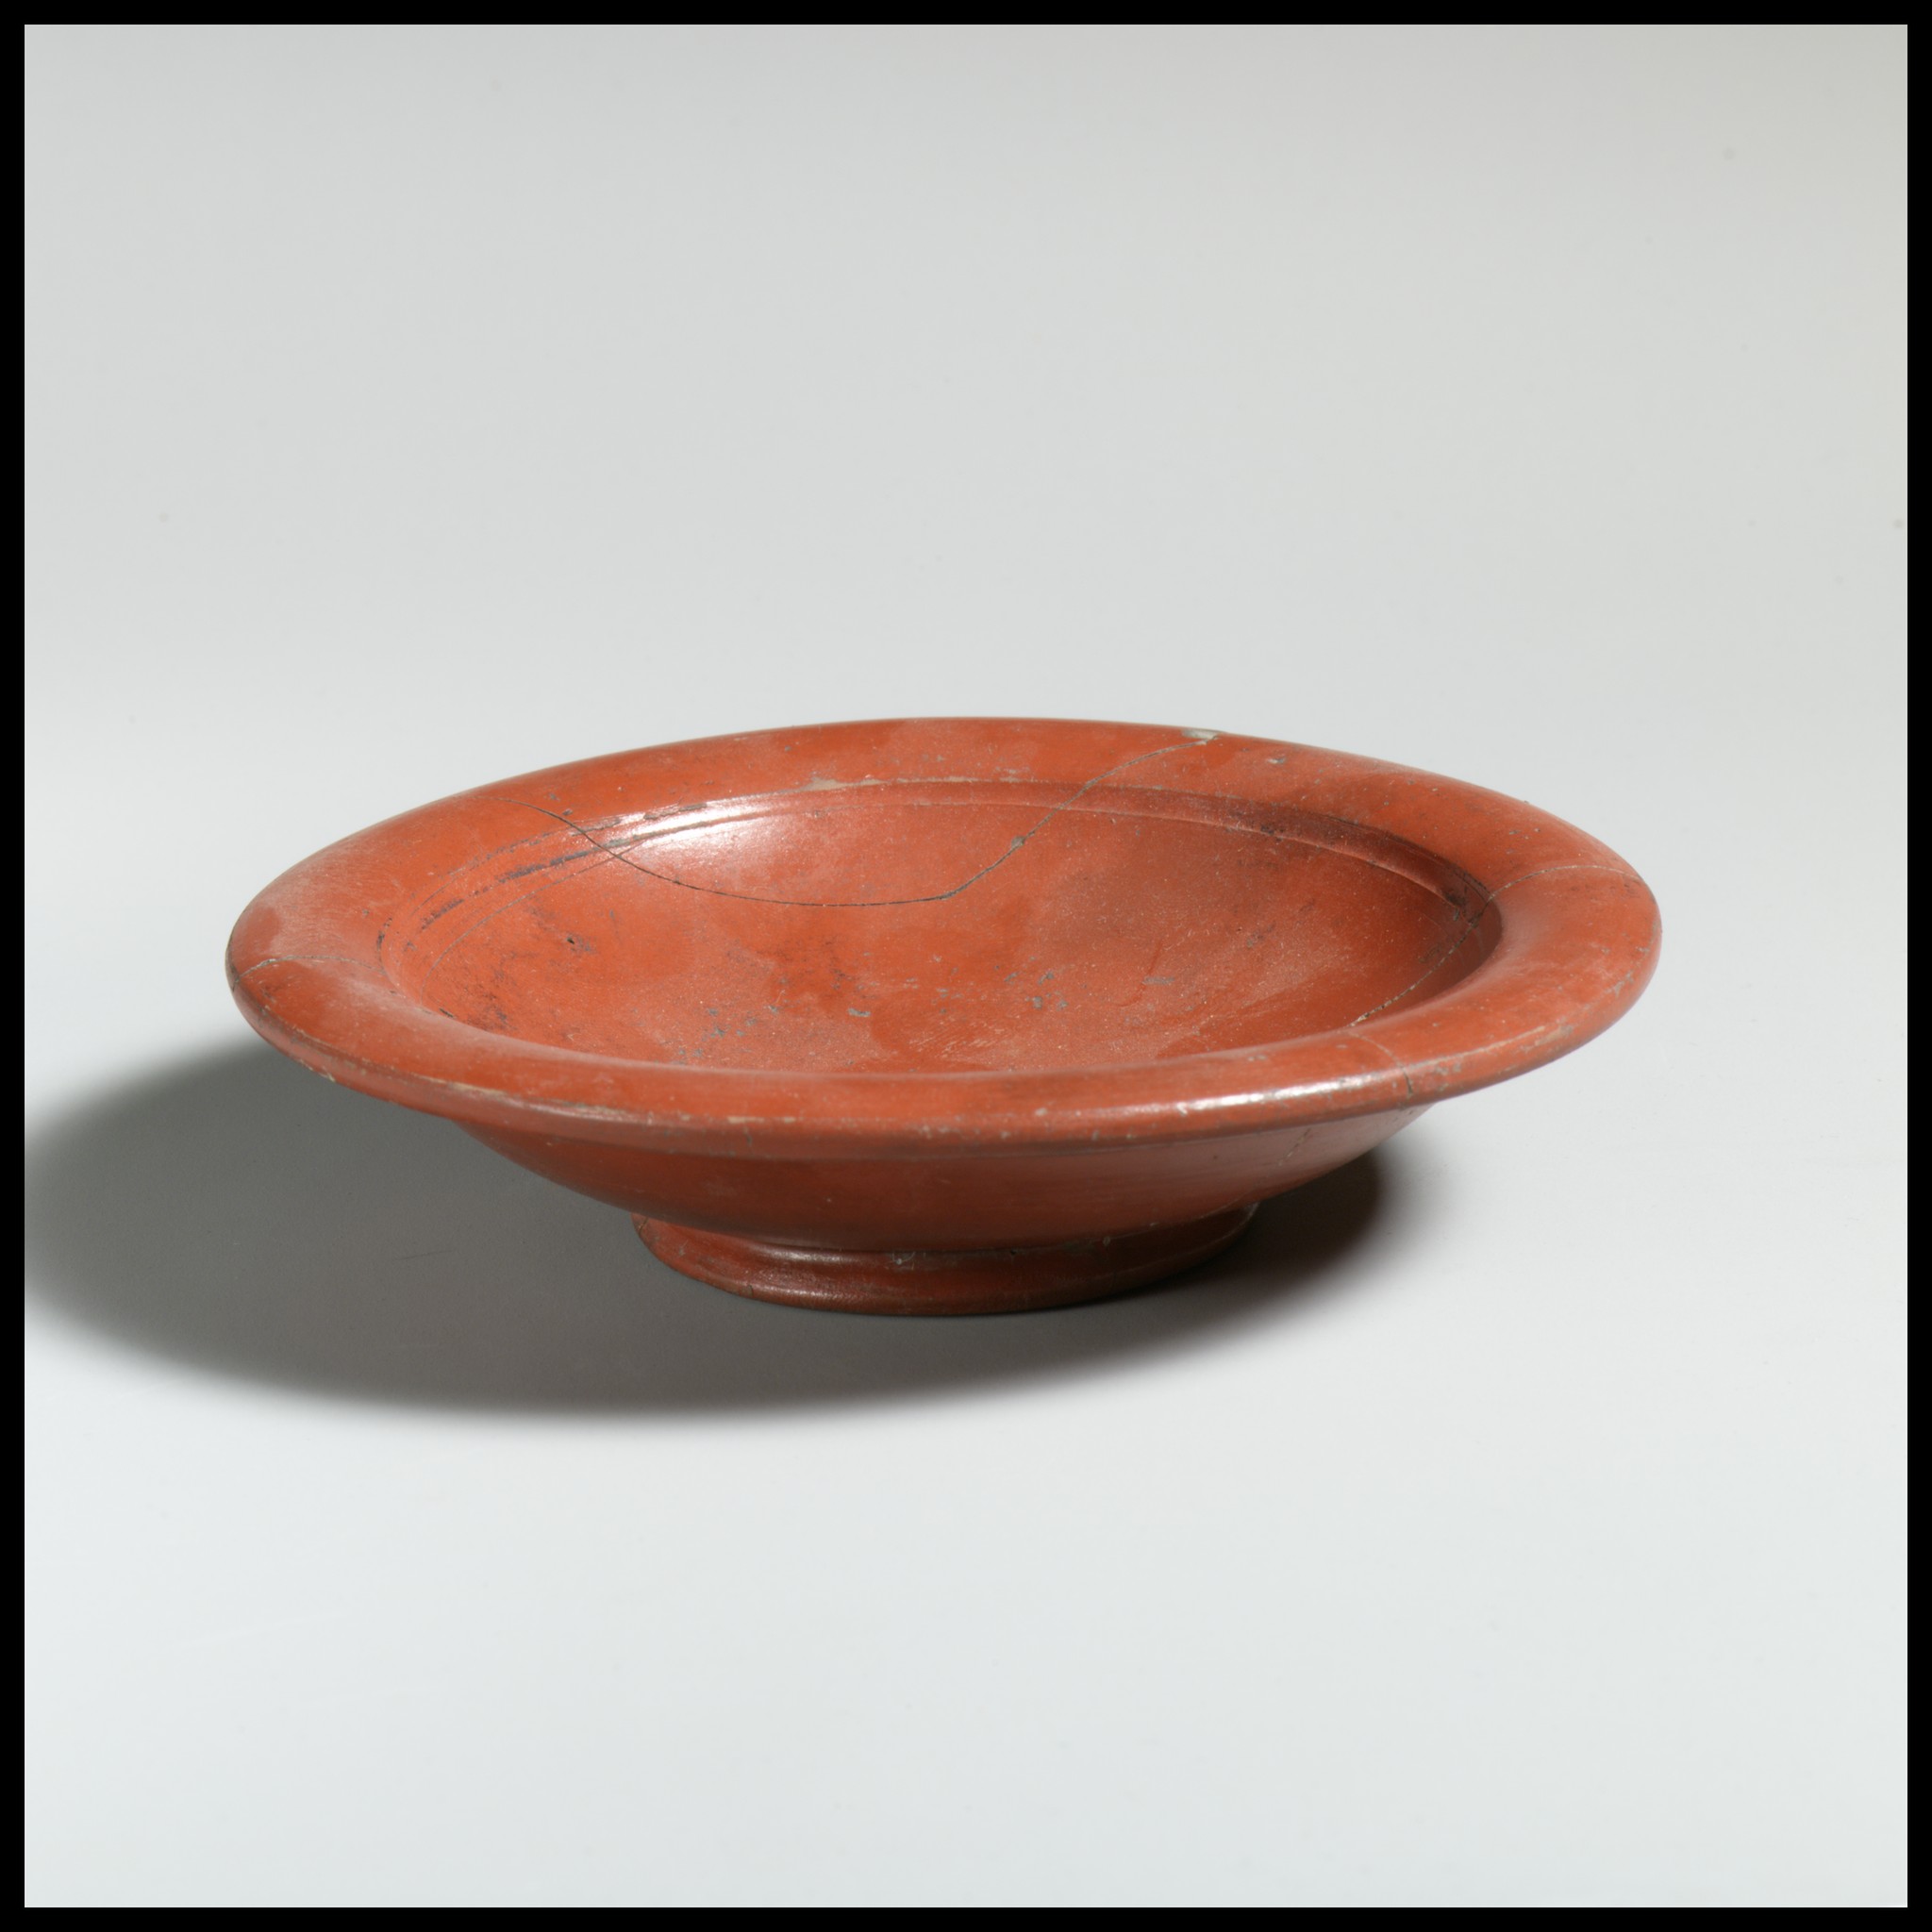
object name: dish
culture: roman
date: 670 BCE-330 CE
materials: terracotta